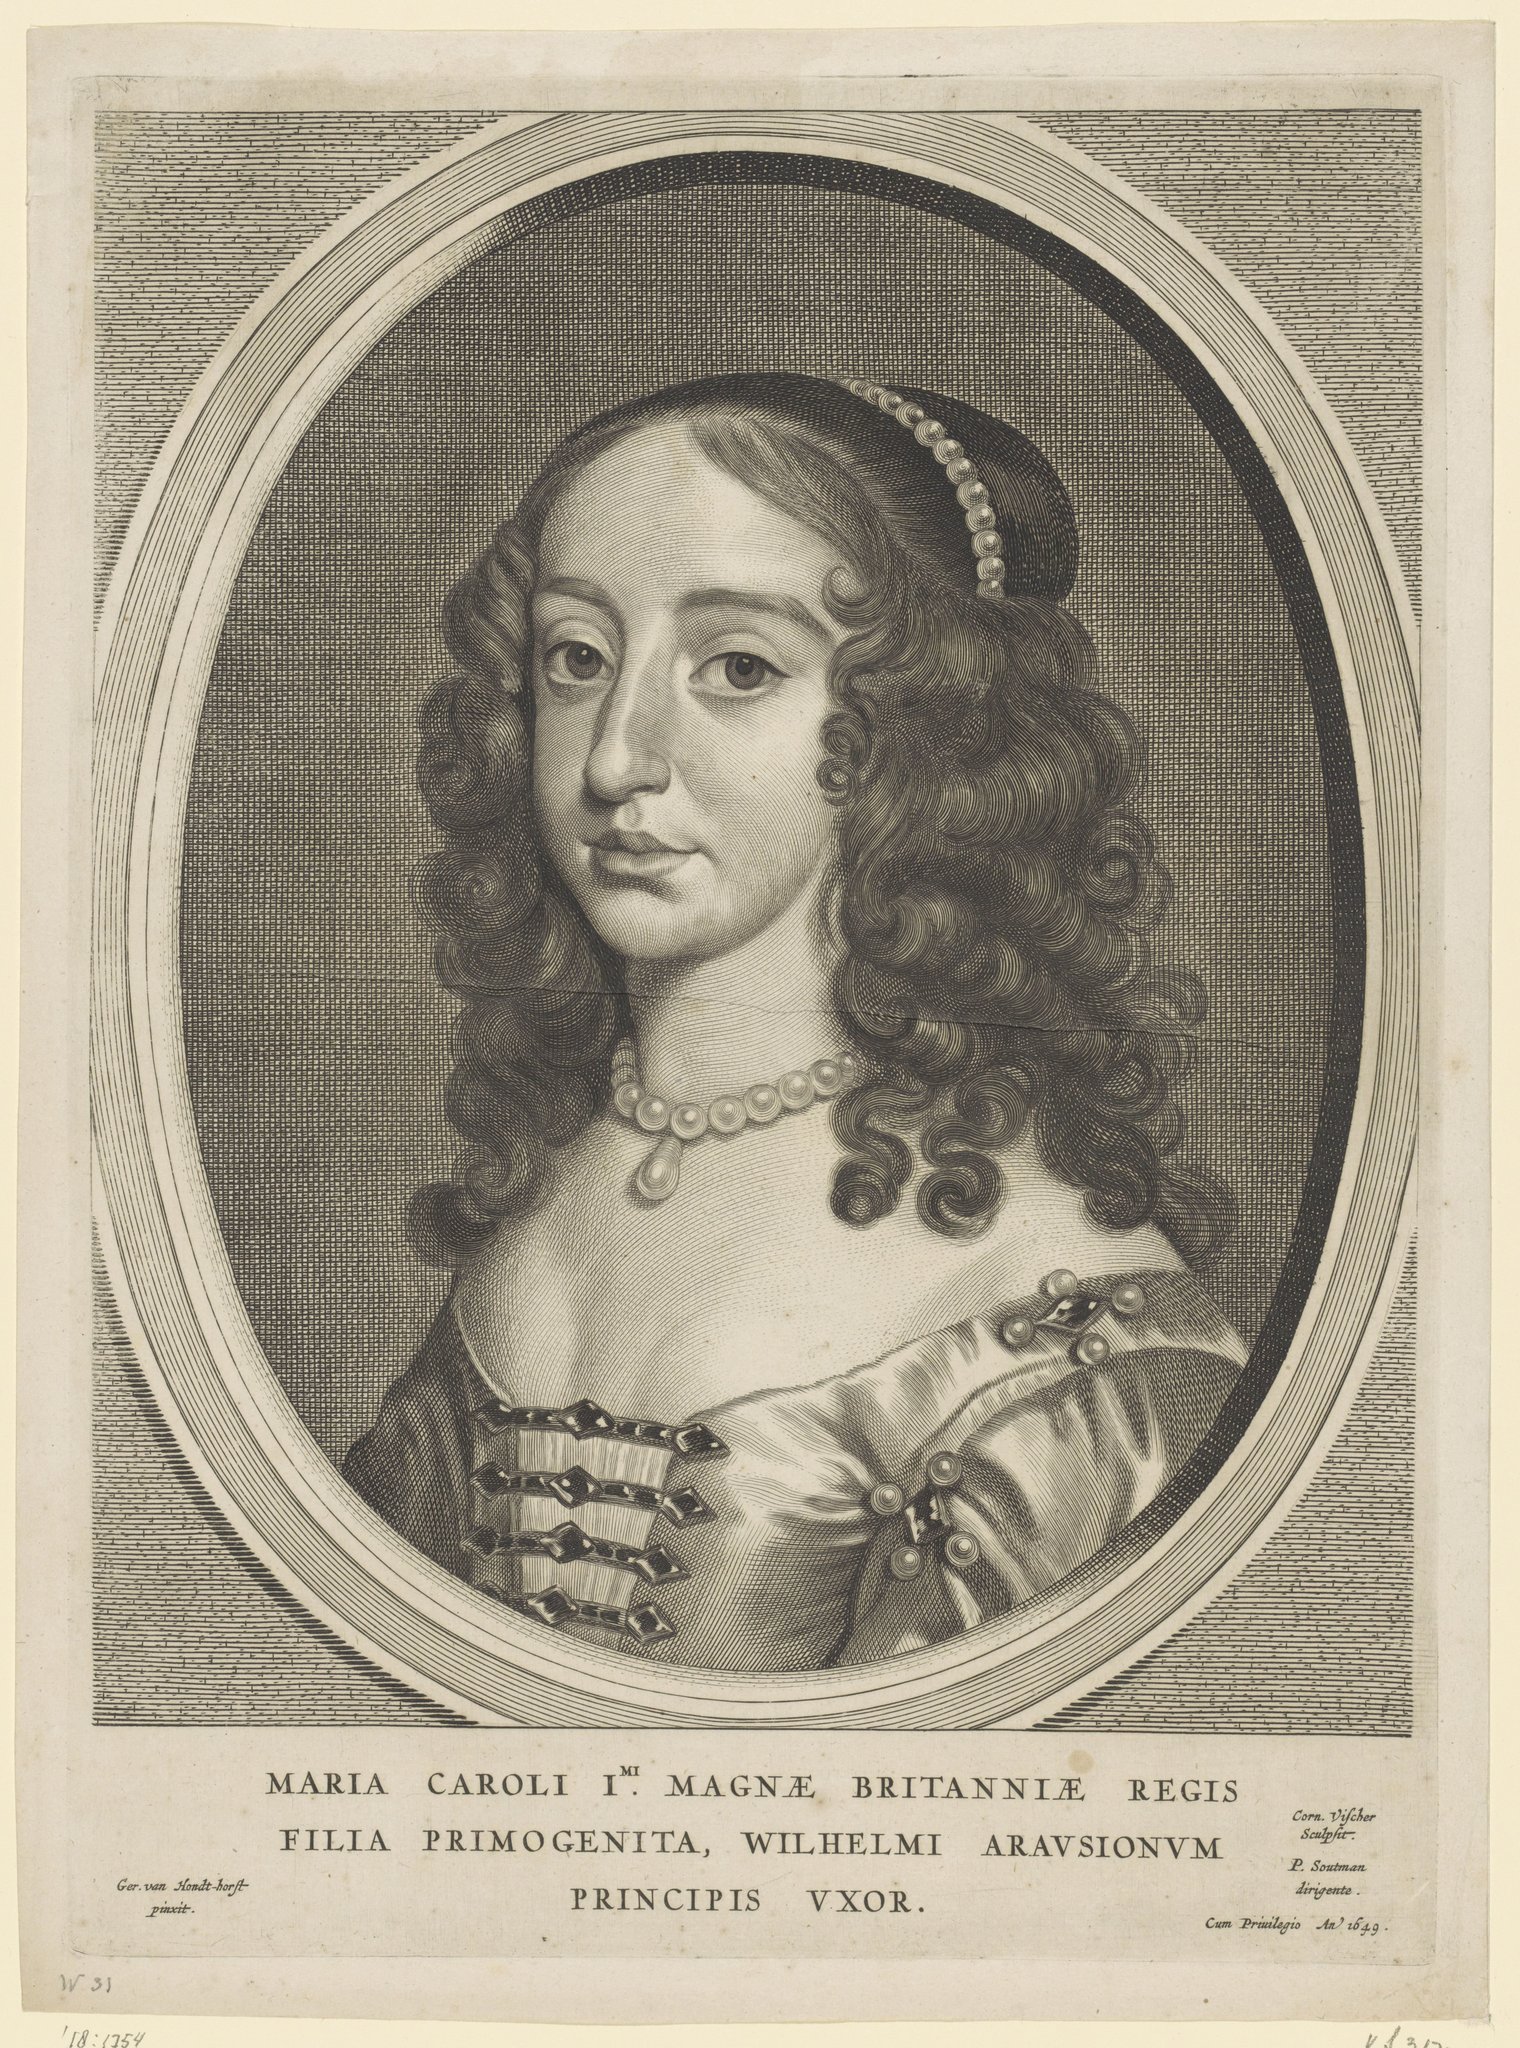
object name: print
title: Fredericus Henricus Illustrissimus Orangiae Princeps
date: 1649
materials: paper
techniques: engraving, etching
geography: haarlem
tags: london, mary henrietta stuart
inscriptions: collector's mark: Lugt 2233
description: Portret van Maria Henrietta in een ovaal. In de ondermarge haar naam.